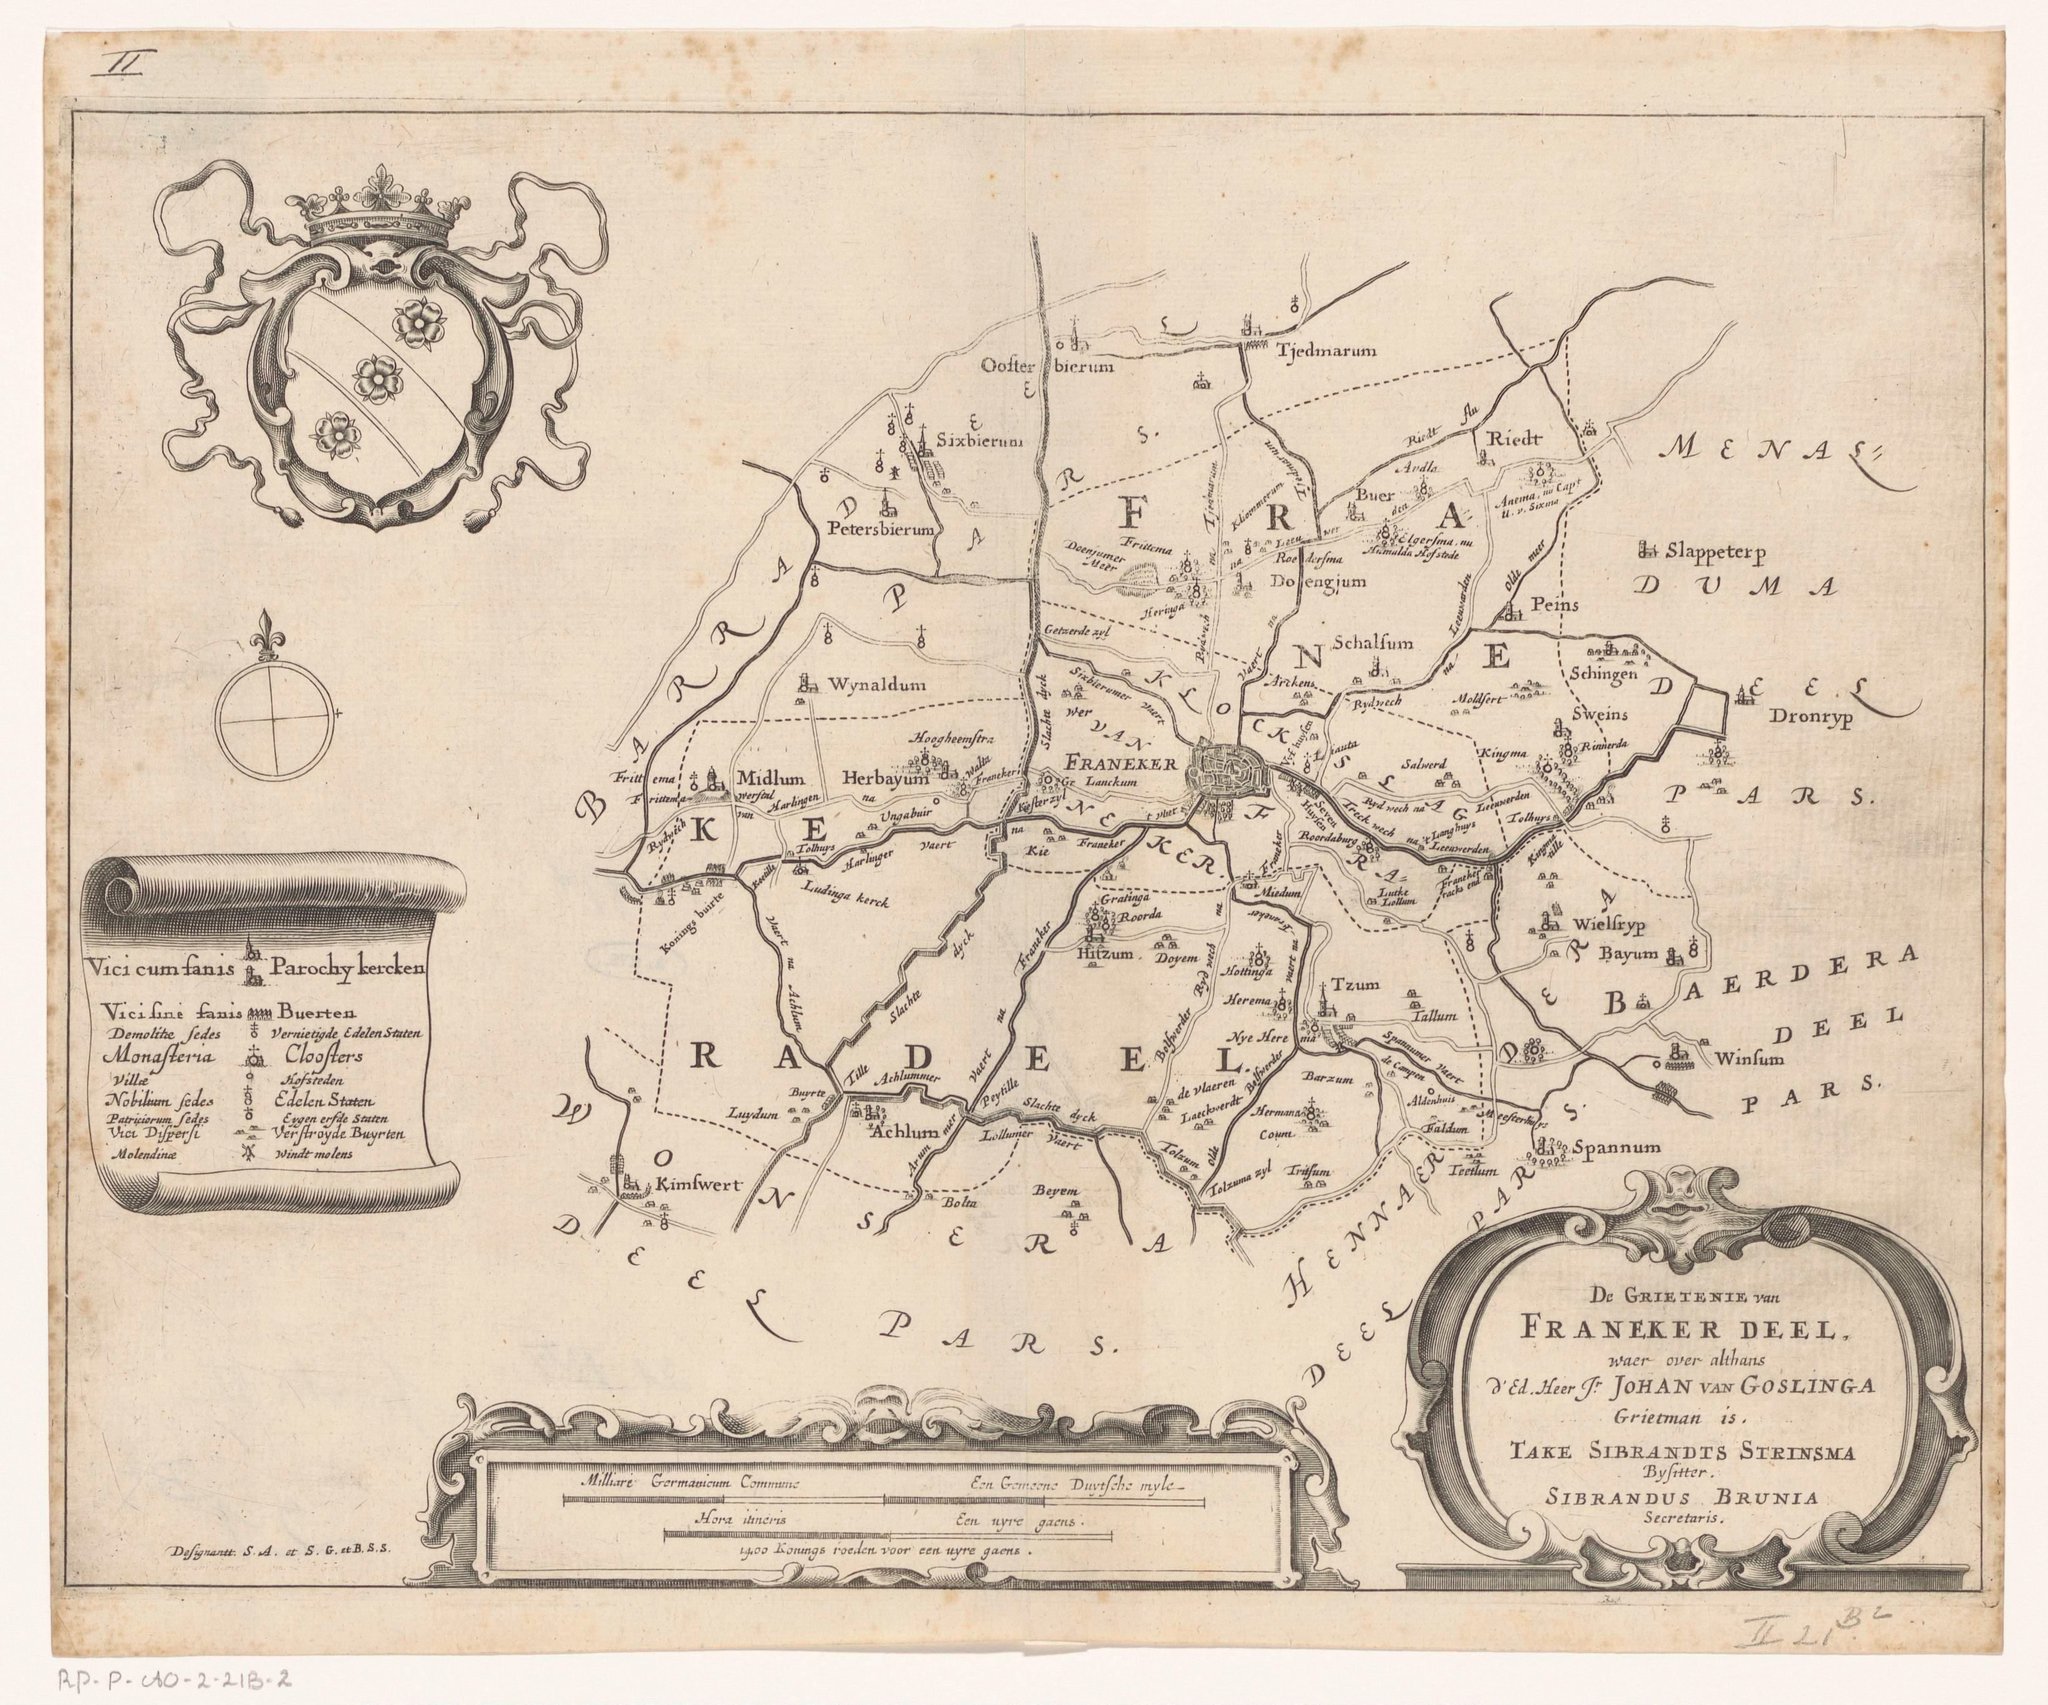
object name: map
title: Kaart van de grietenij Franekeradeel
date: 1664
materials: paper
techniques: engraving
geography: friesland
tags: coat of arms (as symbol of the state, etc.), maps of separate countries or regions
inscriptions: collector's mark: Lugt 2228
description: Linksboven het wapen van Franekeradeel, daaronder legenda. Aan de onderkant twee schaalstokken: Milliare Germanicum commune / Een gemeene Duytsche myle, Hora itineris / Een uyre gaens - 1400 konings roeden voor een uyre gaens. Rechtsonder cartouche met titel en bestuurlijke informatie over de grietenij.